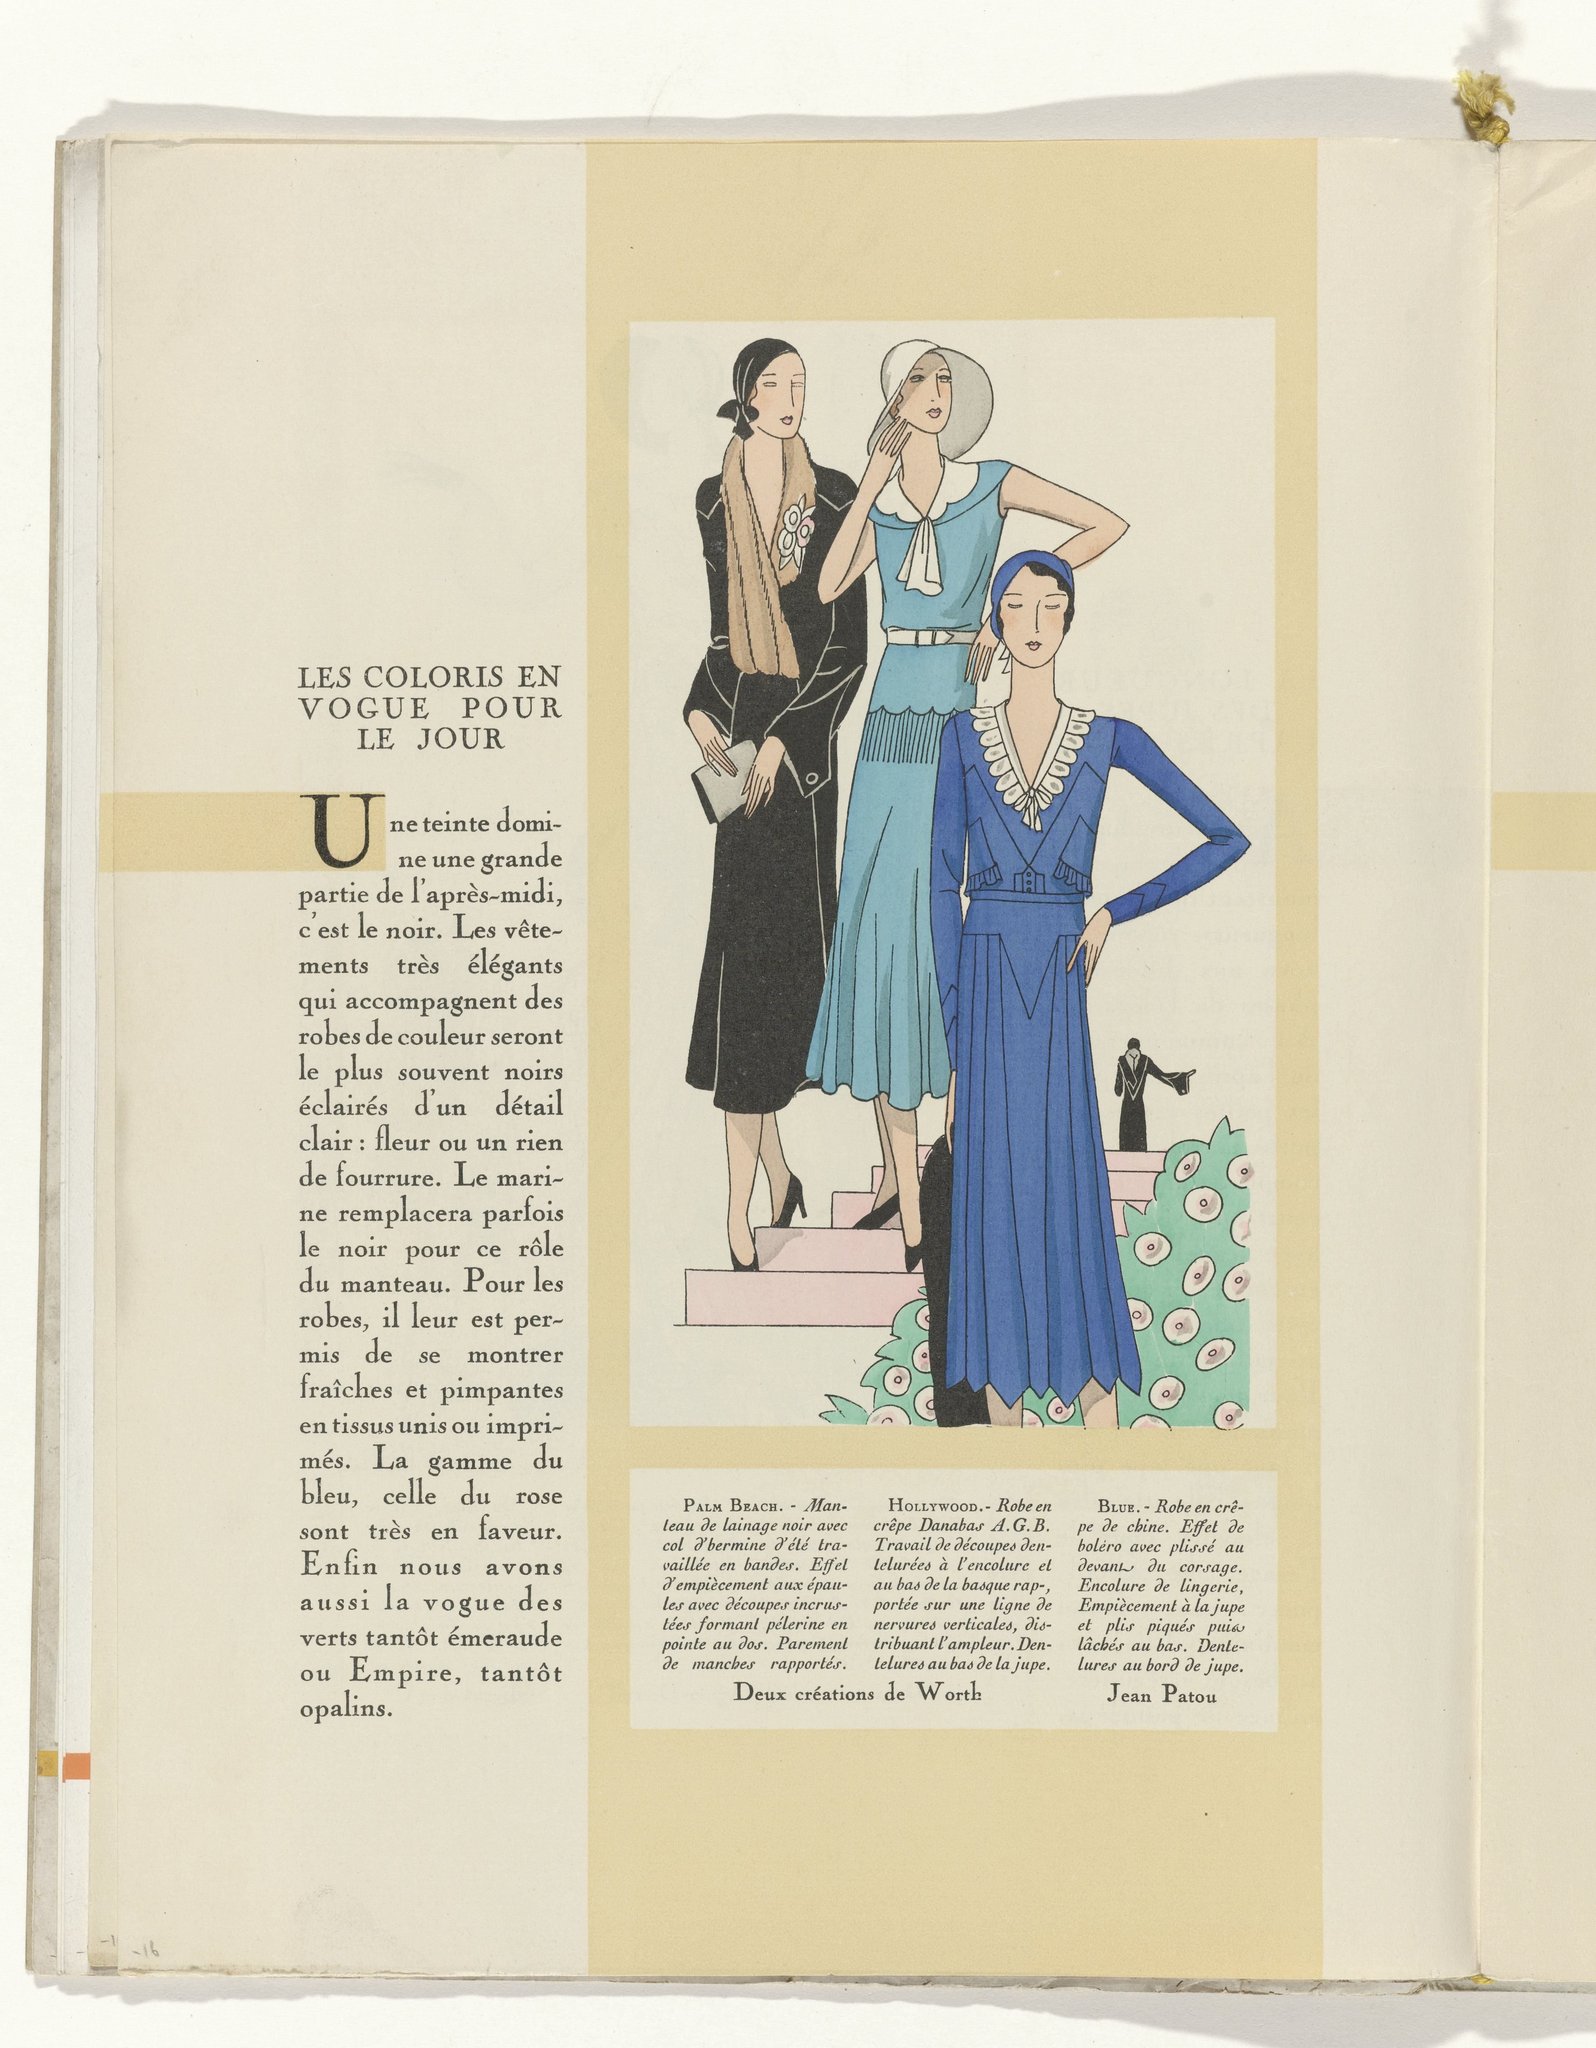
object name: fashion print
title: Art - Goût - Beauté, Feuillets de l' élégance féminine, Mai 1931, No. 129, 11e Année, p. 16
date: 1931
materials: paper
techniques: hand coloring, lithograph, pochoir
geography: paris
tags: coat (+ women's clothes), fashion plates, head-gear: hat (+ women's clothes), dress, gown (+ women's clothes), neck-gear: collar (+ fur used for clothes)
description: Tekst ´Les coloris en vogue pour le jour´. Afbeelding van een mantel van zwarte wol met hermelijnen kraag en een japon crêpe Danabas A.G.B. van Worth en een japon van crêpe de chine van Jean Patou. Pagina uit het modetijdschrift Art-Goût-Beauté (1920-1933).